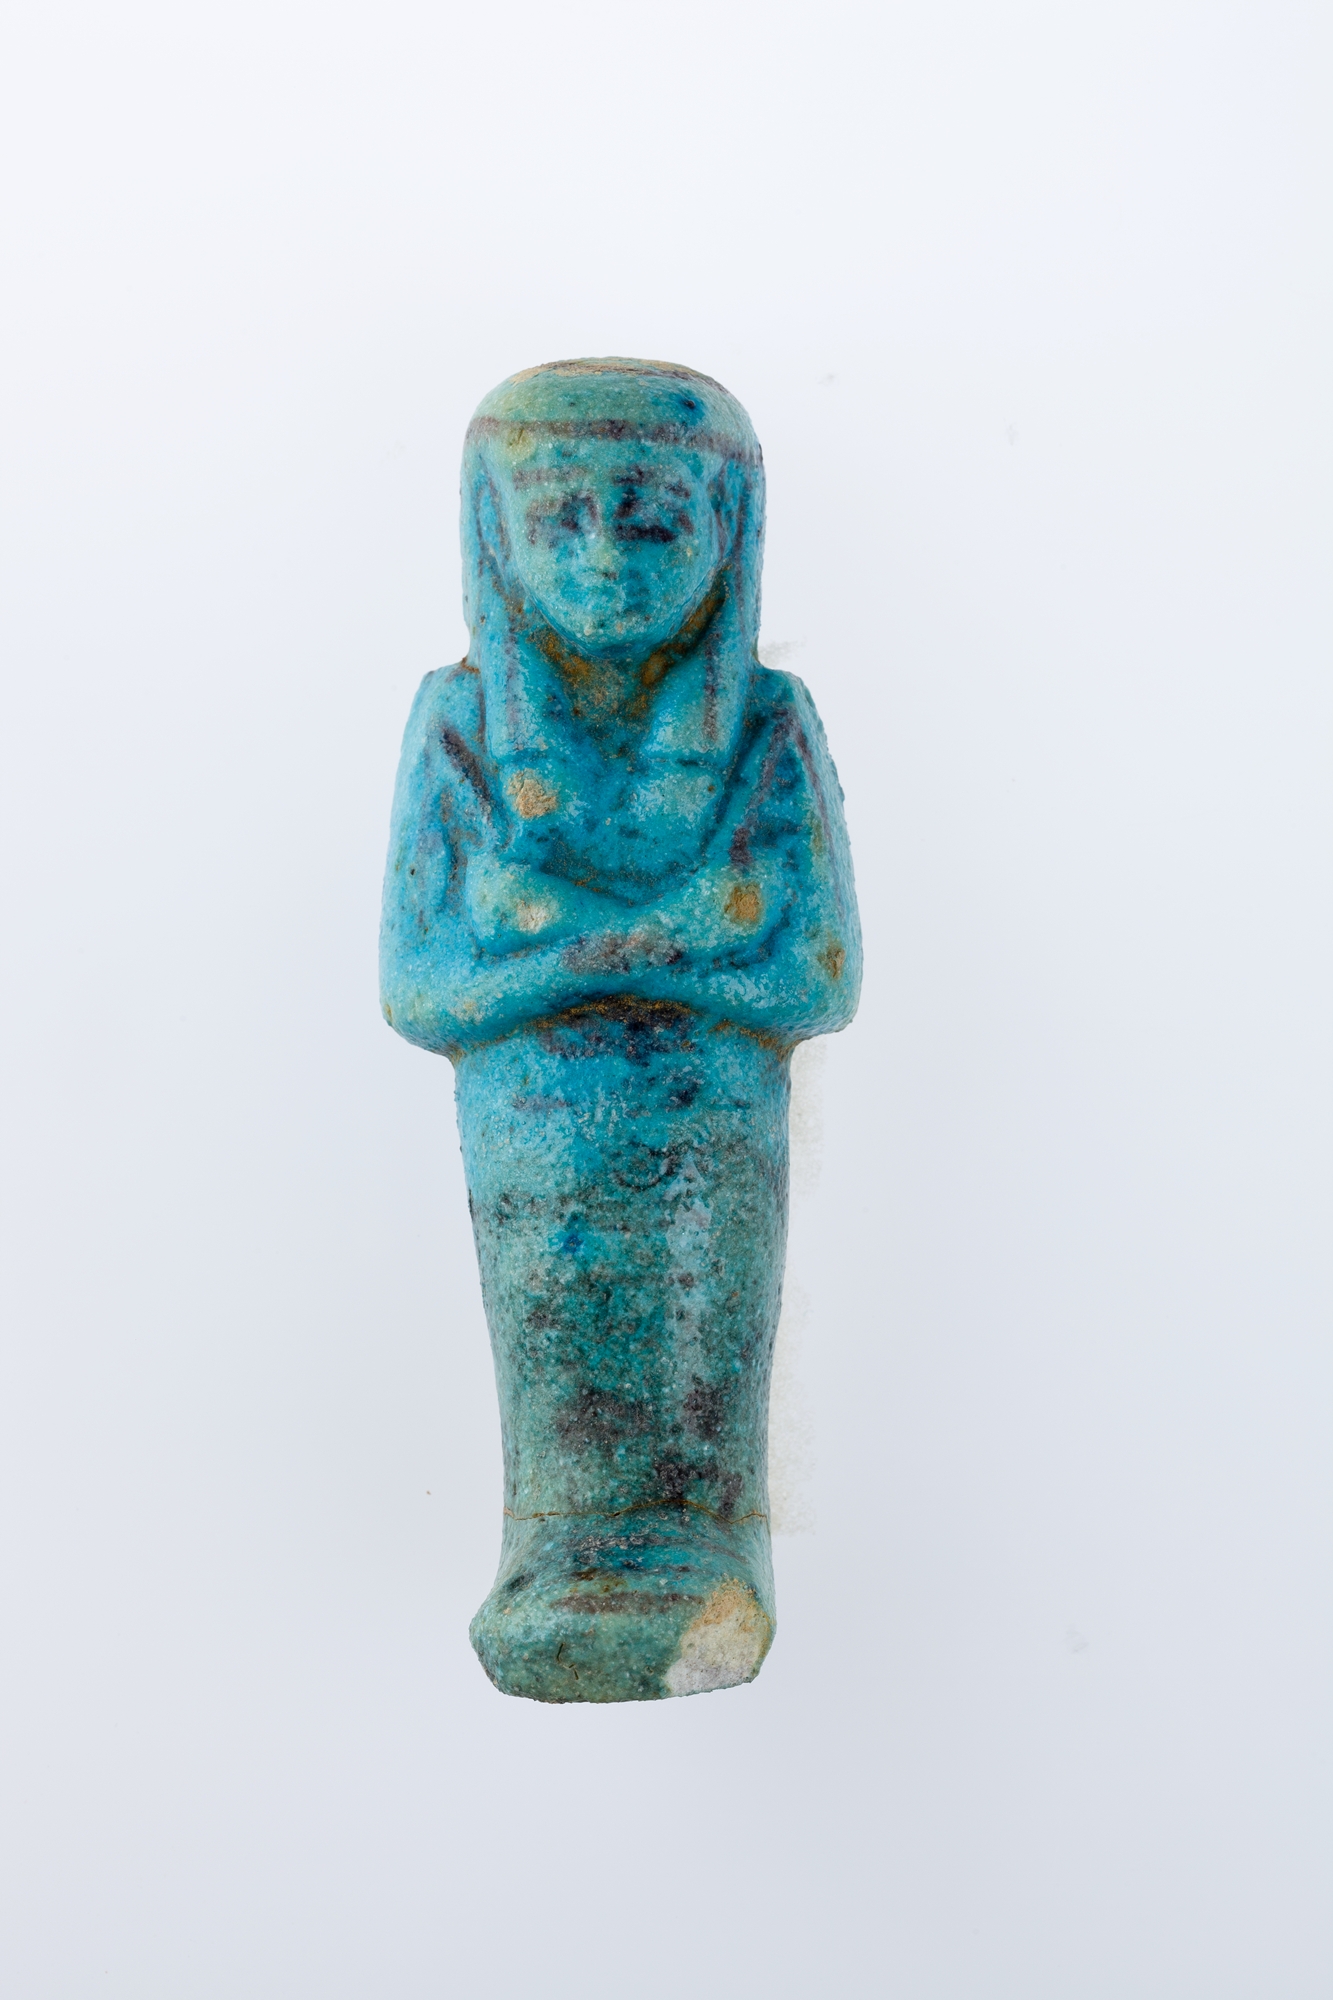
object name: shabti, henettawy c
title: Worker Shabti of Henettawy (C), Daughter of Isetemkheb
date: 990-970 BCE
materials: faience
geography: egypt